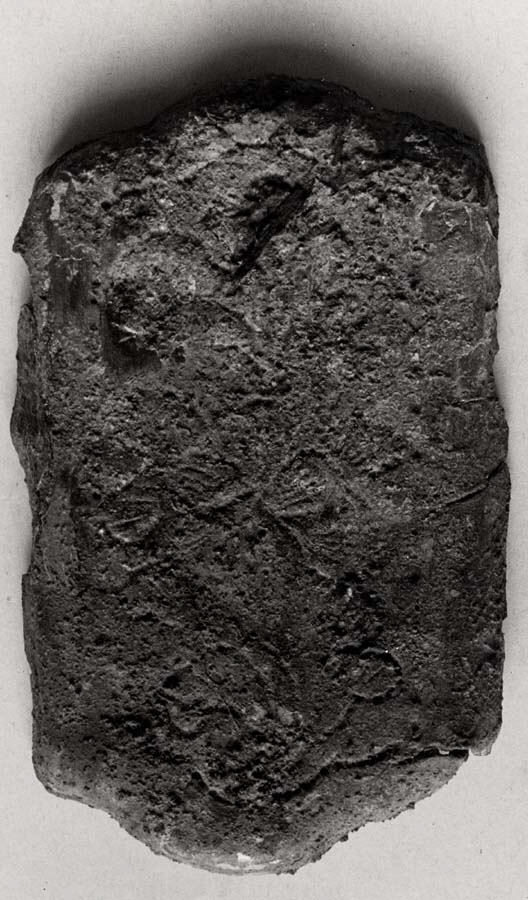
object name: ornament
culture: korean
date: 918-1392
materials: bronze, gilt